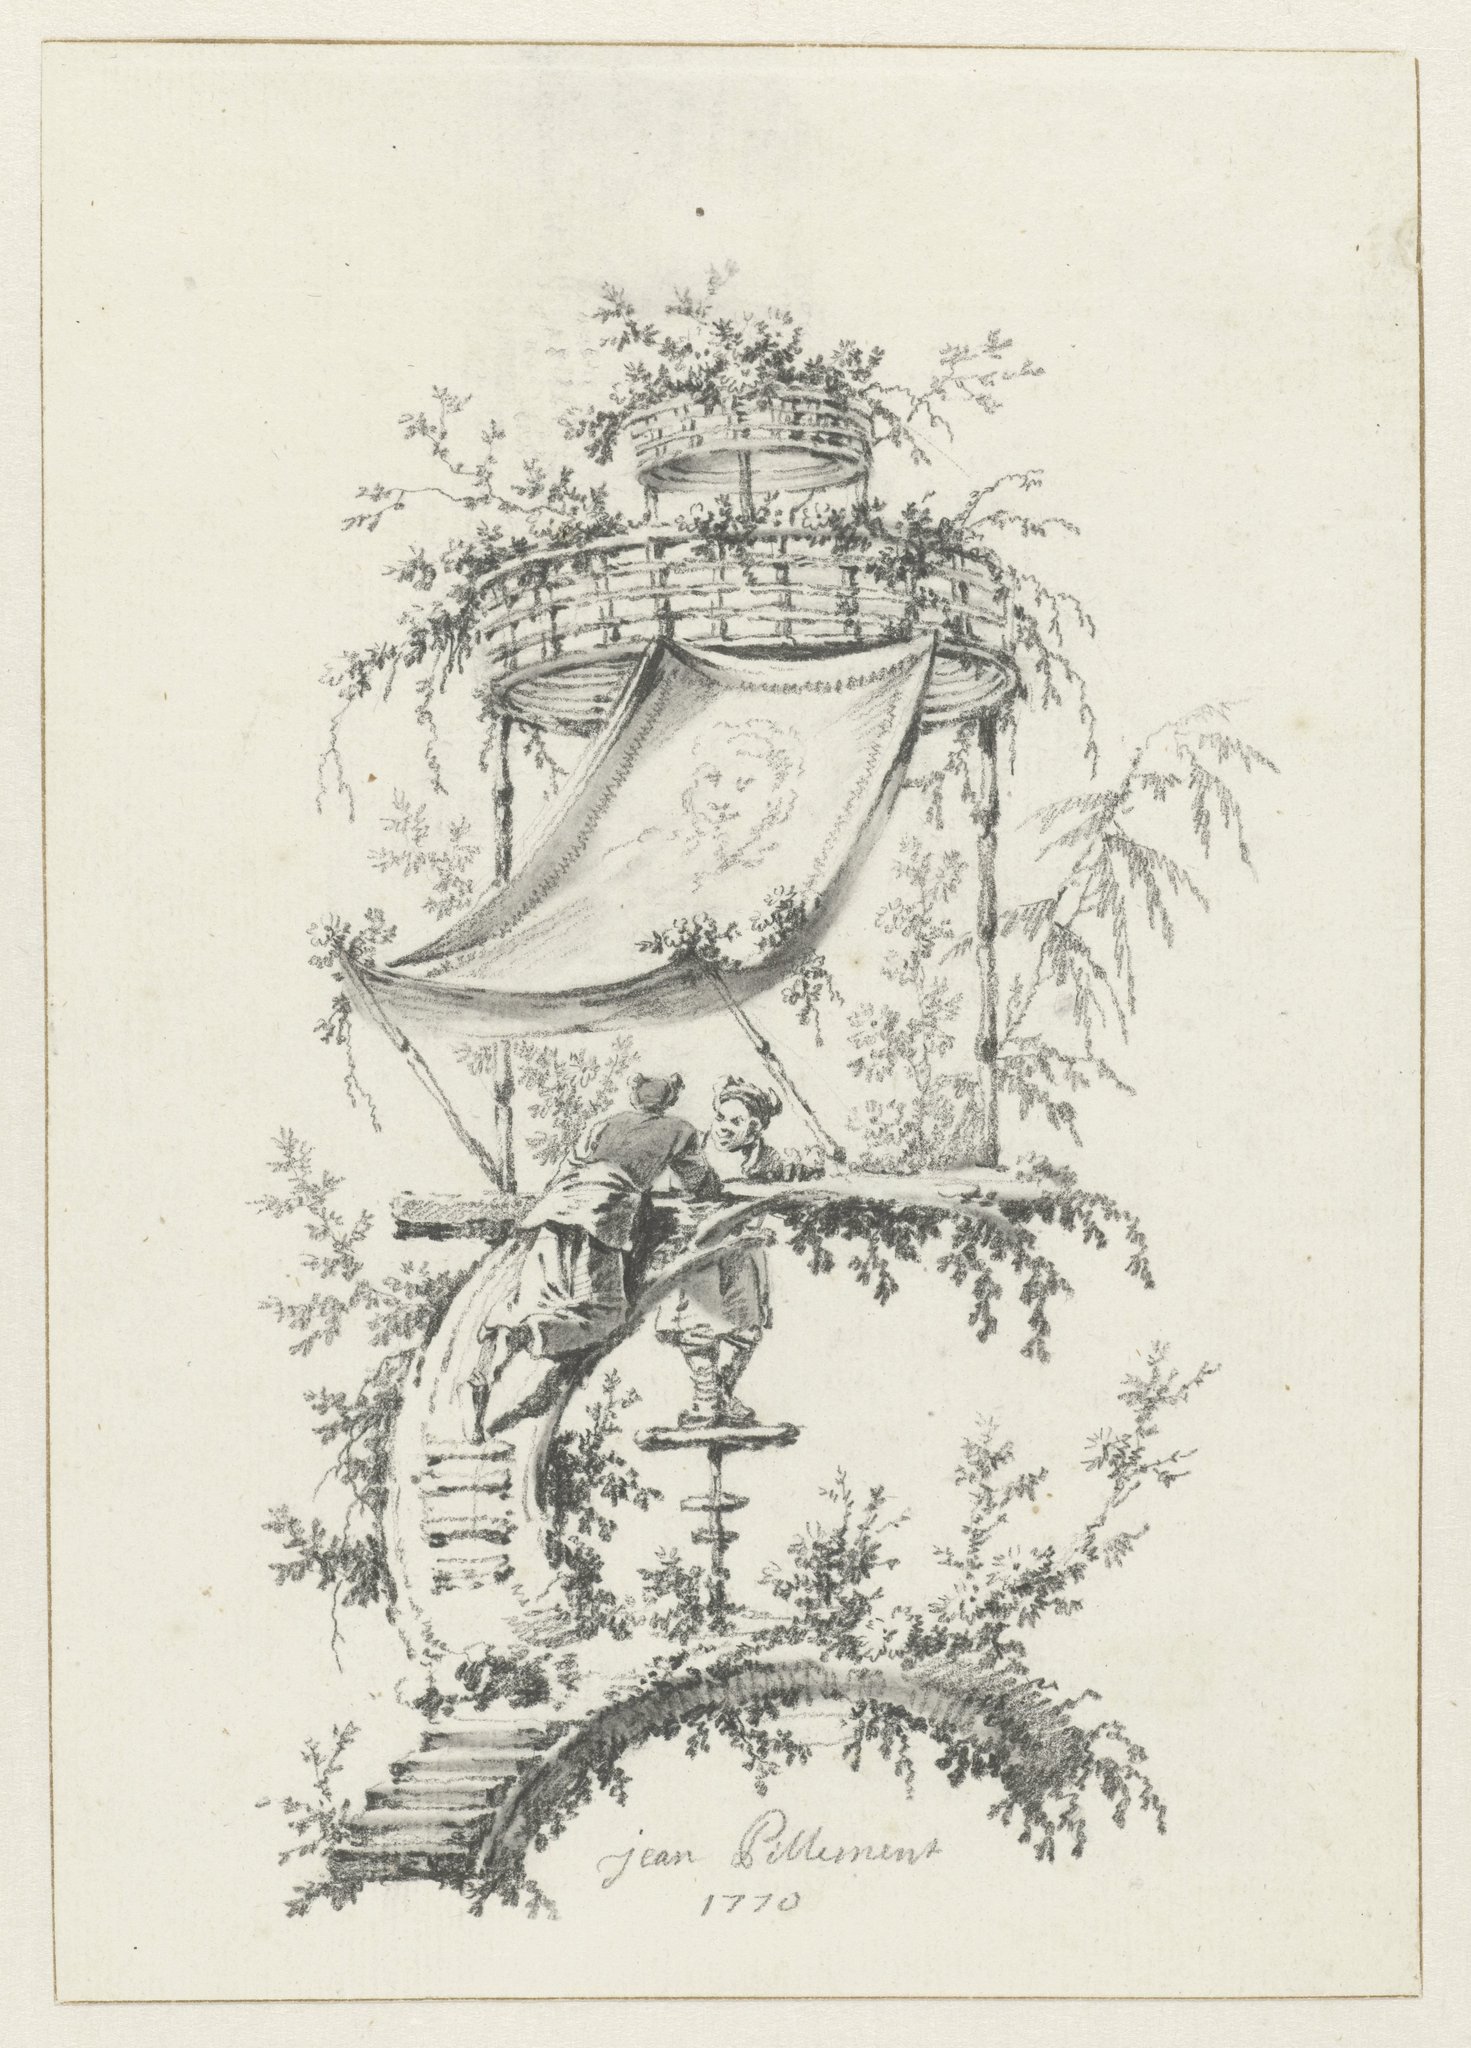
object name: design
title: Ornamentale ontwerpen in chinoiserie-stijl voor Deuxième Cahier de six Baraques Chinoises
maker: jean baptiste pillement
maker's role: designer, draughtsman, print maker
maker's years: 1728-1808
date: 1770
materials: chalk, paper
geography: paris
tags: viola, violoncello; double bass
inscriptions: collector's mark, verso, lower left: Lugt 2165, signature and date, recto, lower centre, black chalk: ‘jean Pillement // 1770’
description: Blad uit serie ornamentale composities in chinoiserie-stijl, ontwerpen voor "Deuxième Cahier de six Baraques Chinoises".